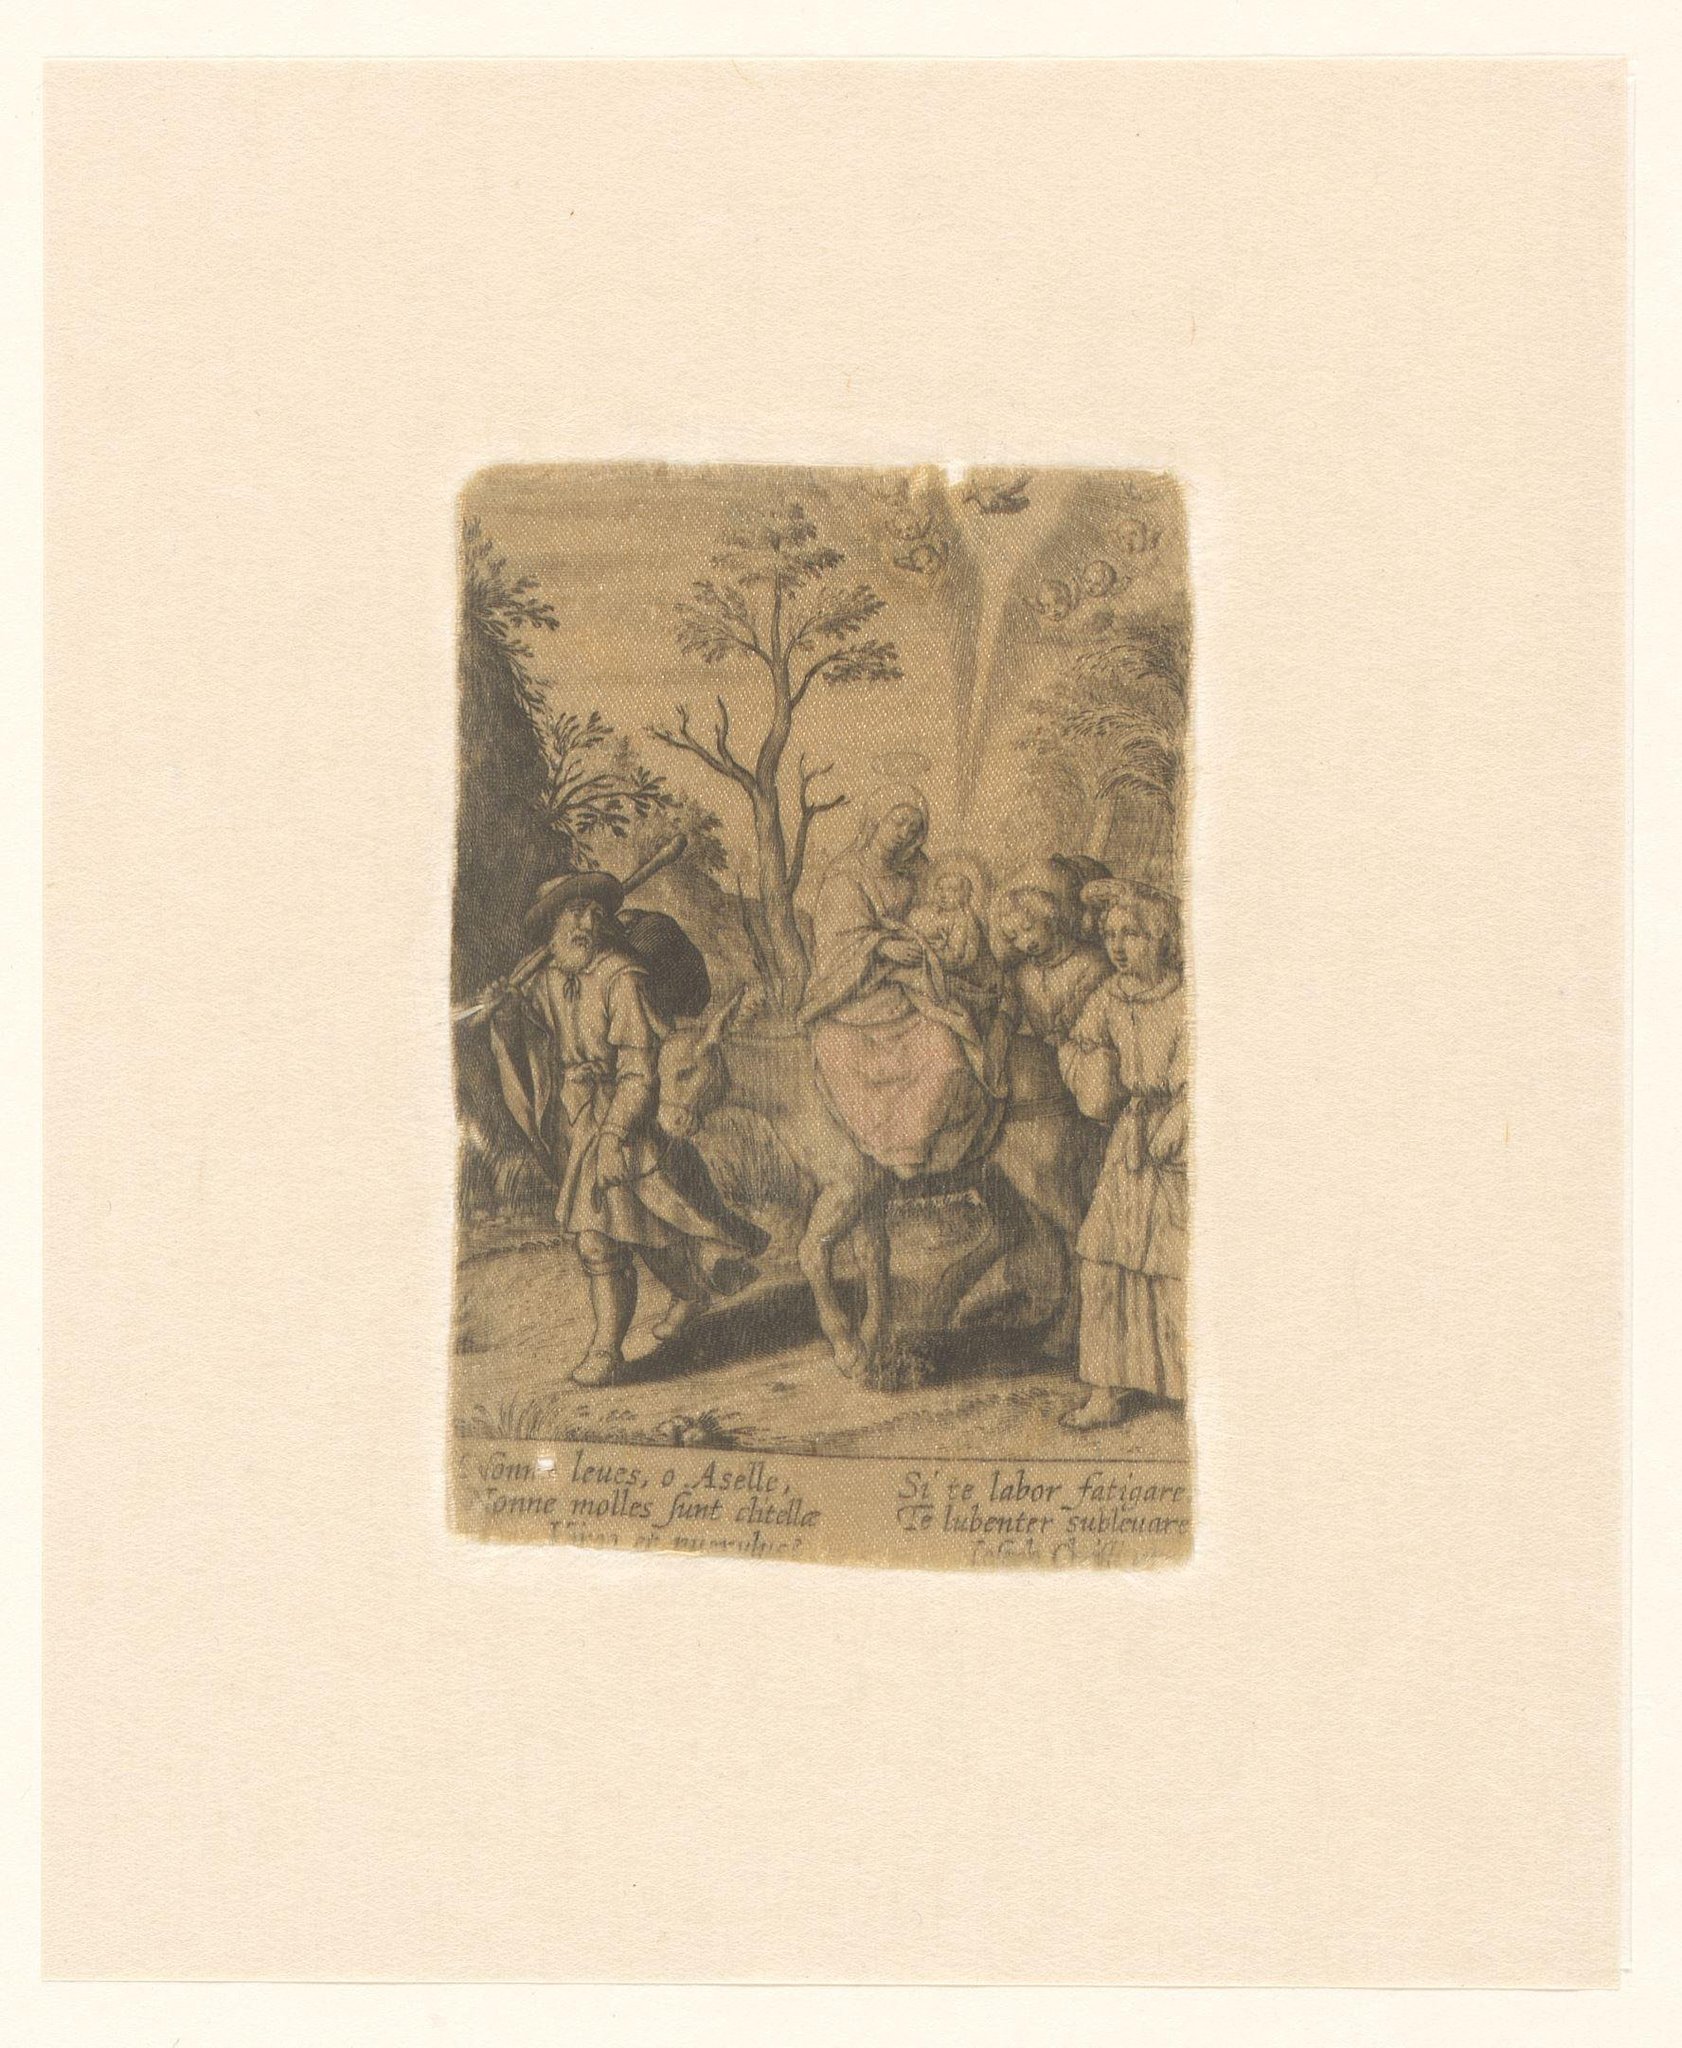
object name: print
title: Vita Deiparæ Virginis Mariæ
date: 1577-1619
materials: silk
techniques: engraving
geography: antwerp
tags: the flight into egypt: mary, joseph, the child (and sometimes others) on their way; mary usually riding on an ass (+ angel(s)), holy ghost represented as a dove (in flames)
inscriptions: collector's mark: Lugt 2228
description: In de marge een zesregelig onderschrift, in twee kolommen, in het Latijn.